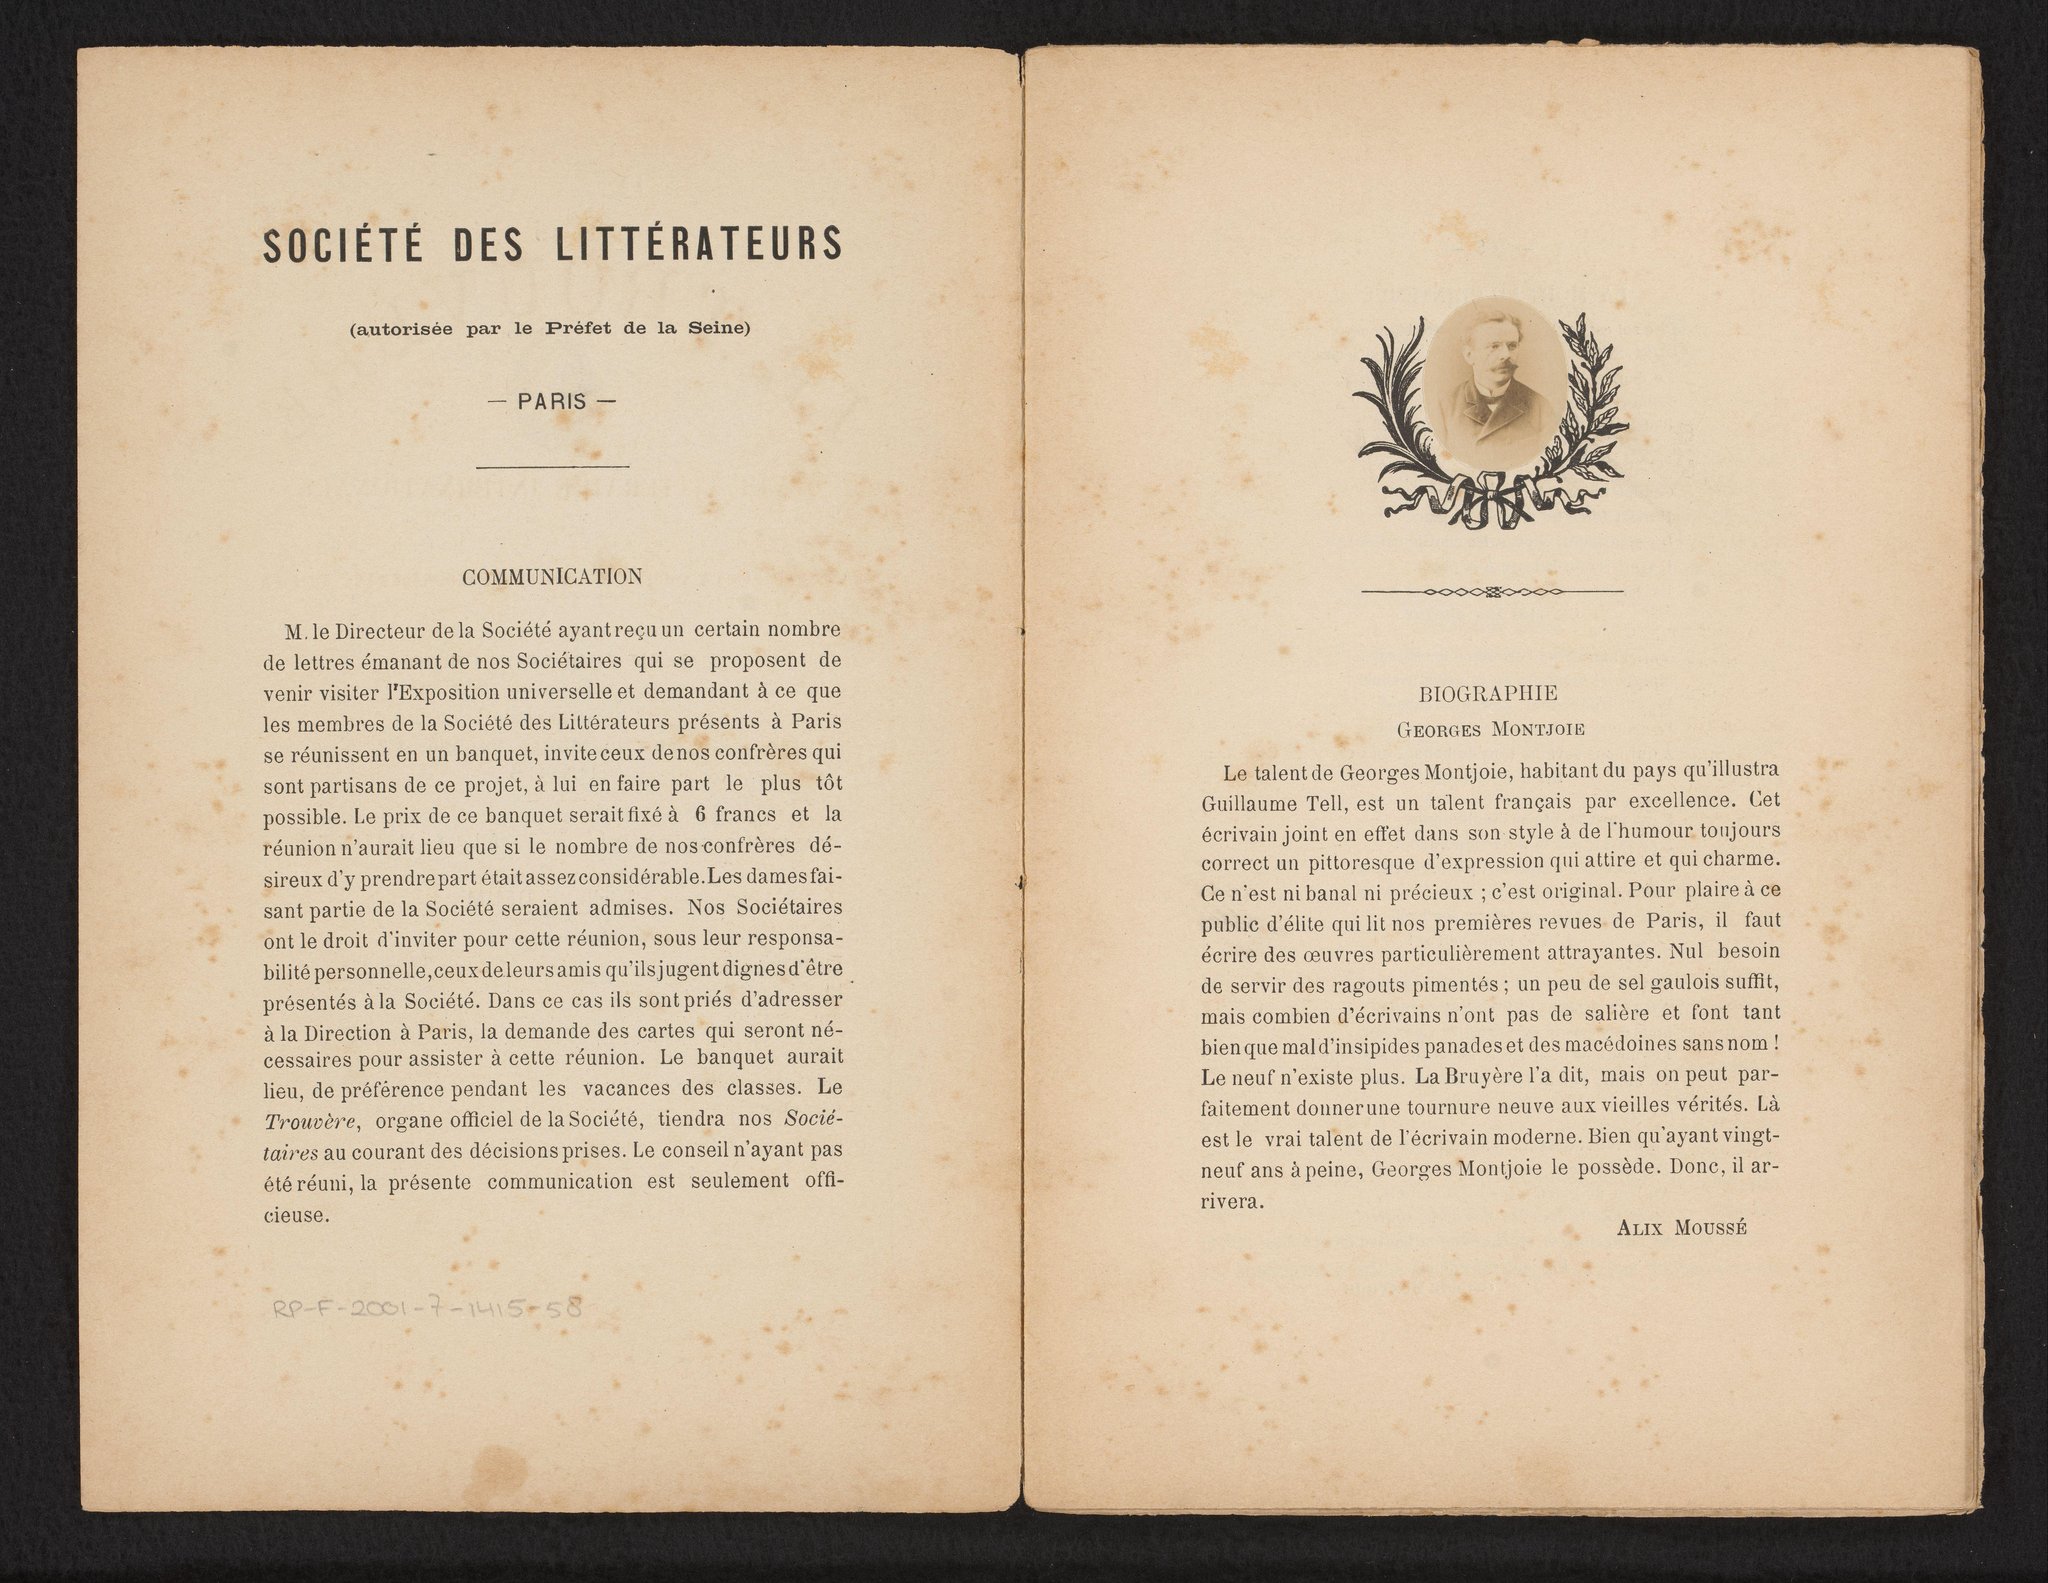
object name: page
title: Portret van Georges Montjoie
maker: Anonymous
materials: photographic support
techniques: albumen print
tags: historical persons